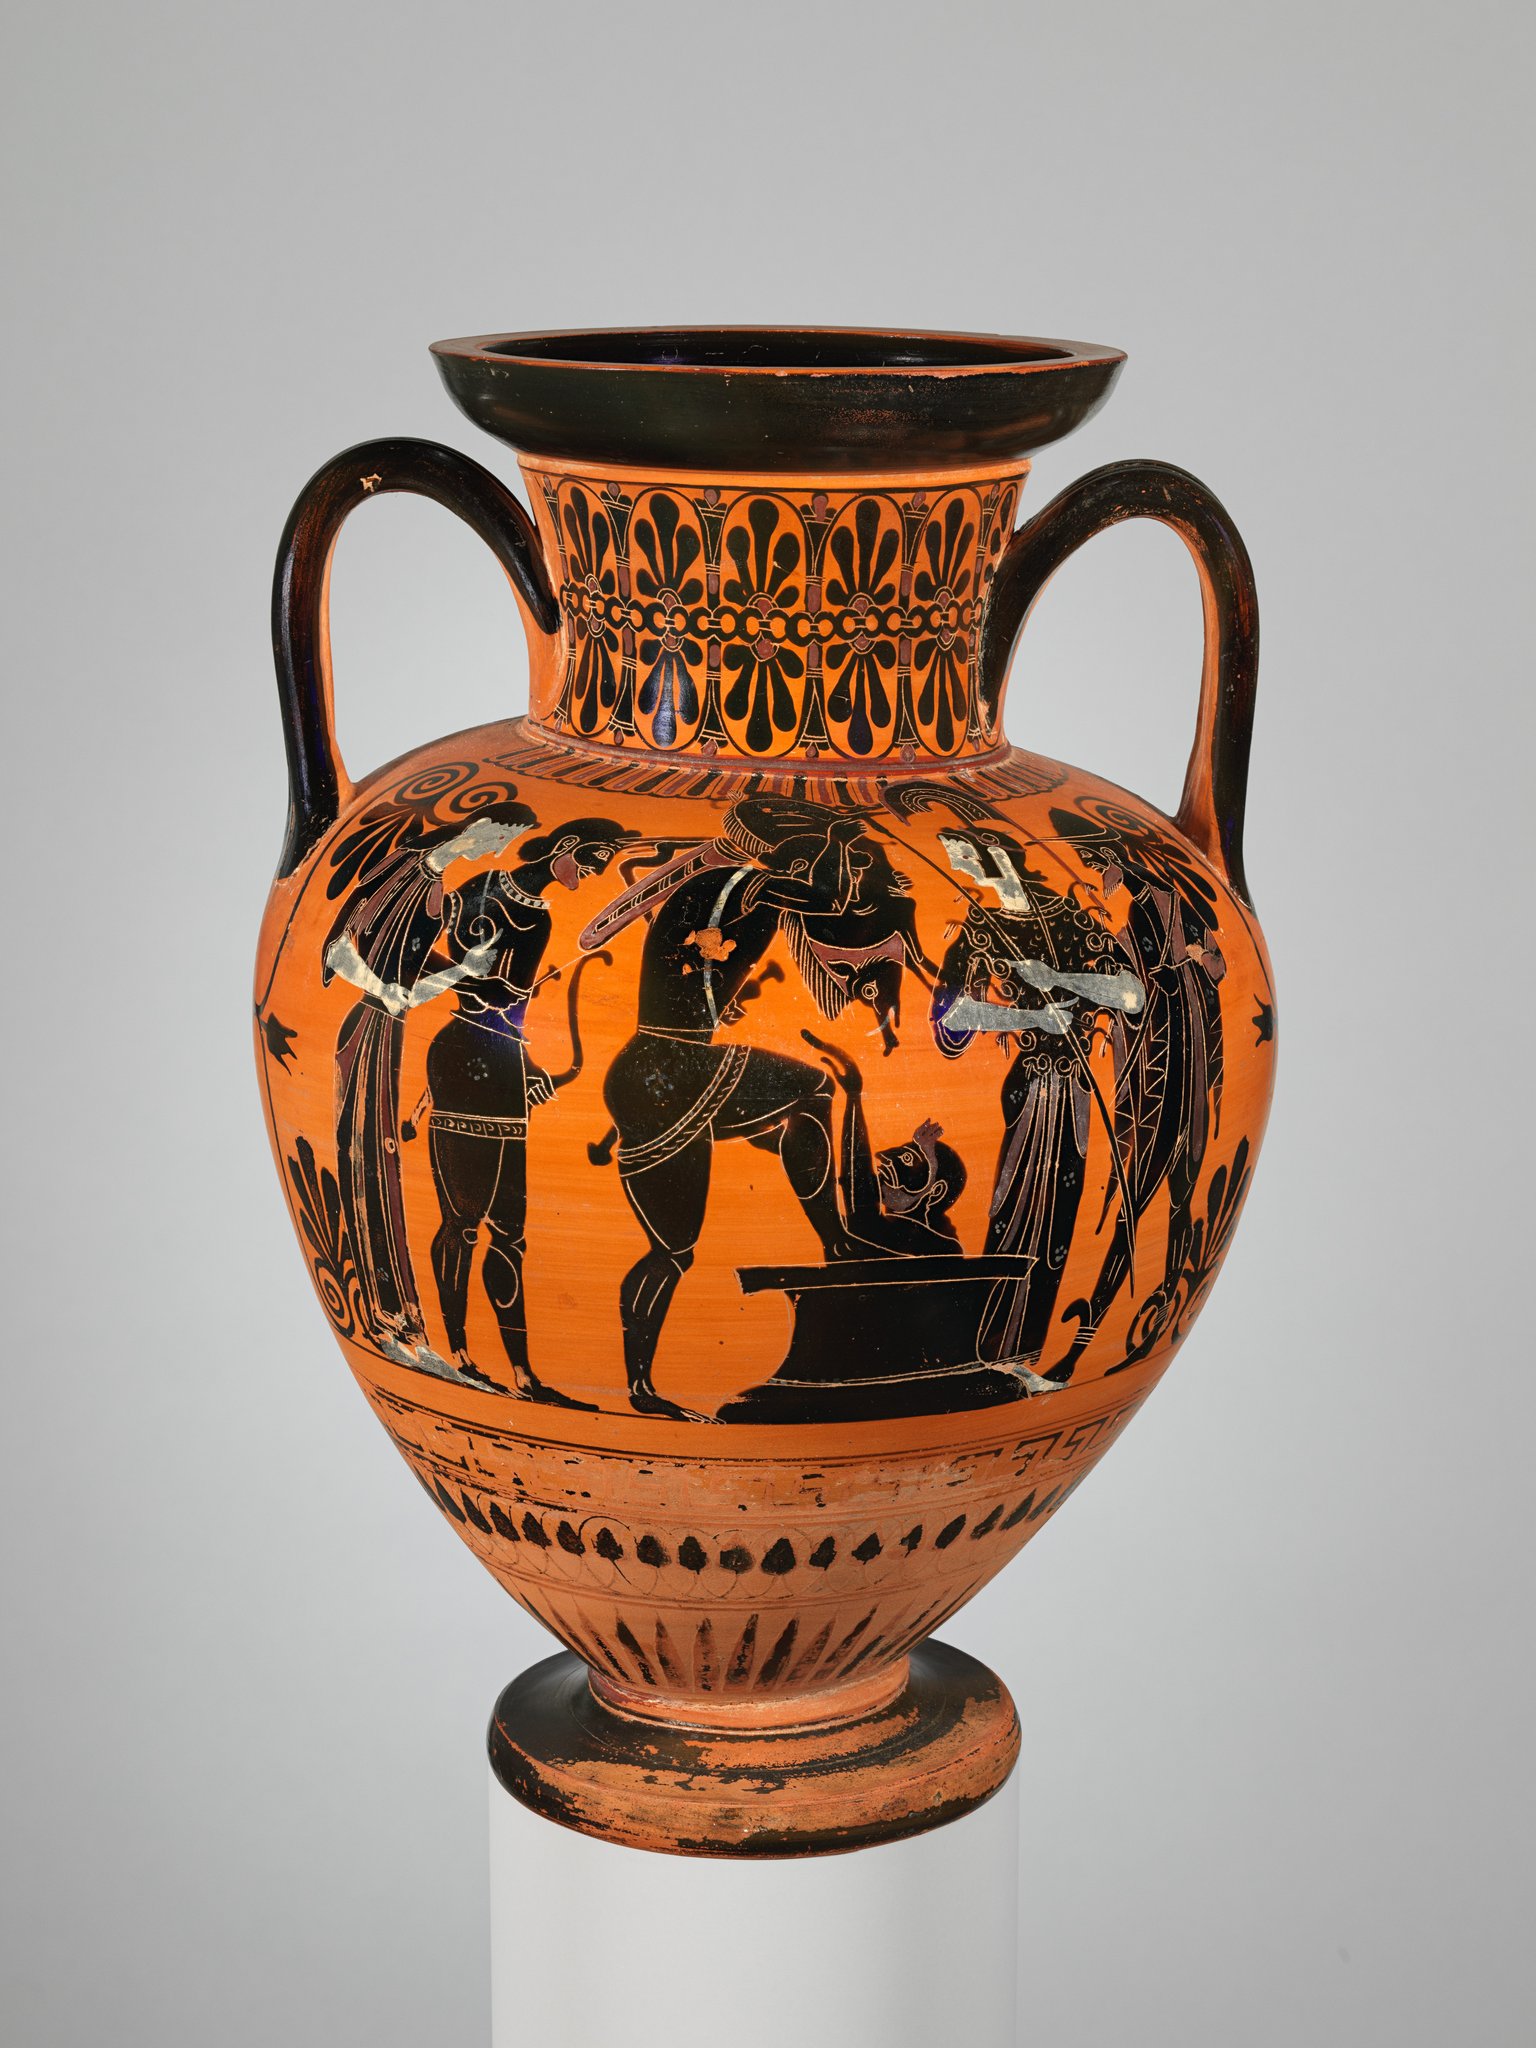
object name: neck amphora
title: Terracotta neck-amphora (jar)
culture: greek, attic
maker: antimenes painter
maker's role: artist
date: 520 BCE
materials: terracotta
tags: shields,achilles,boars,herakles,ajax